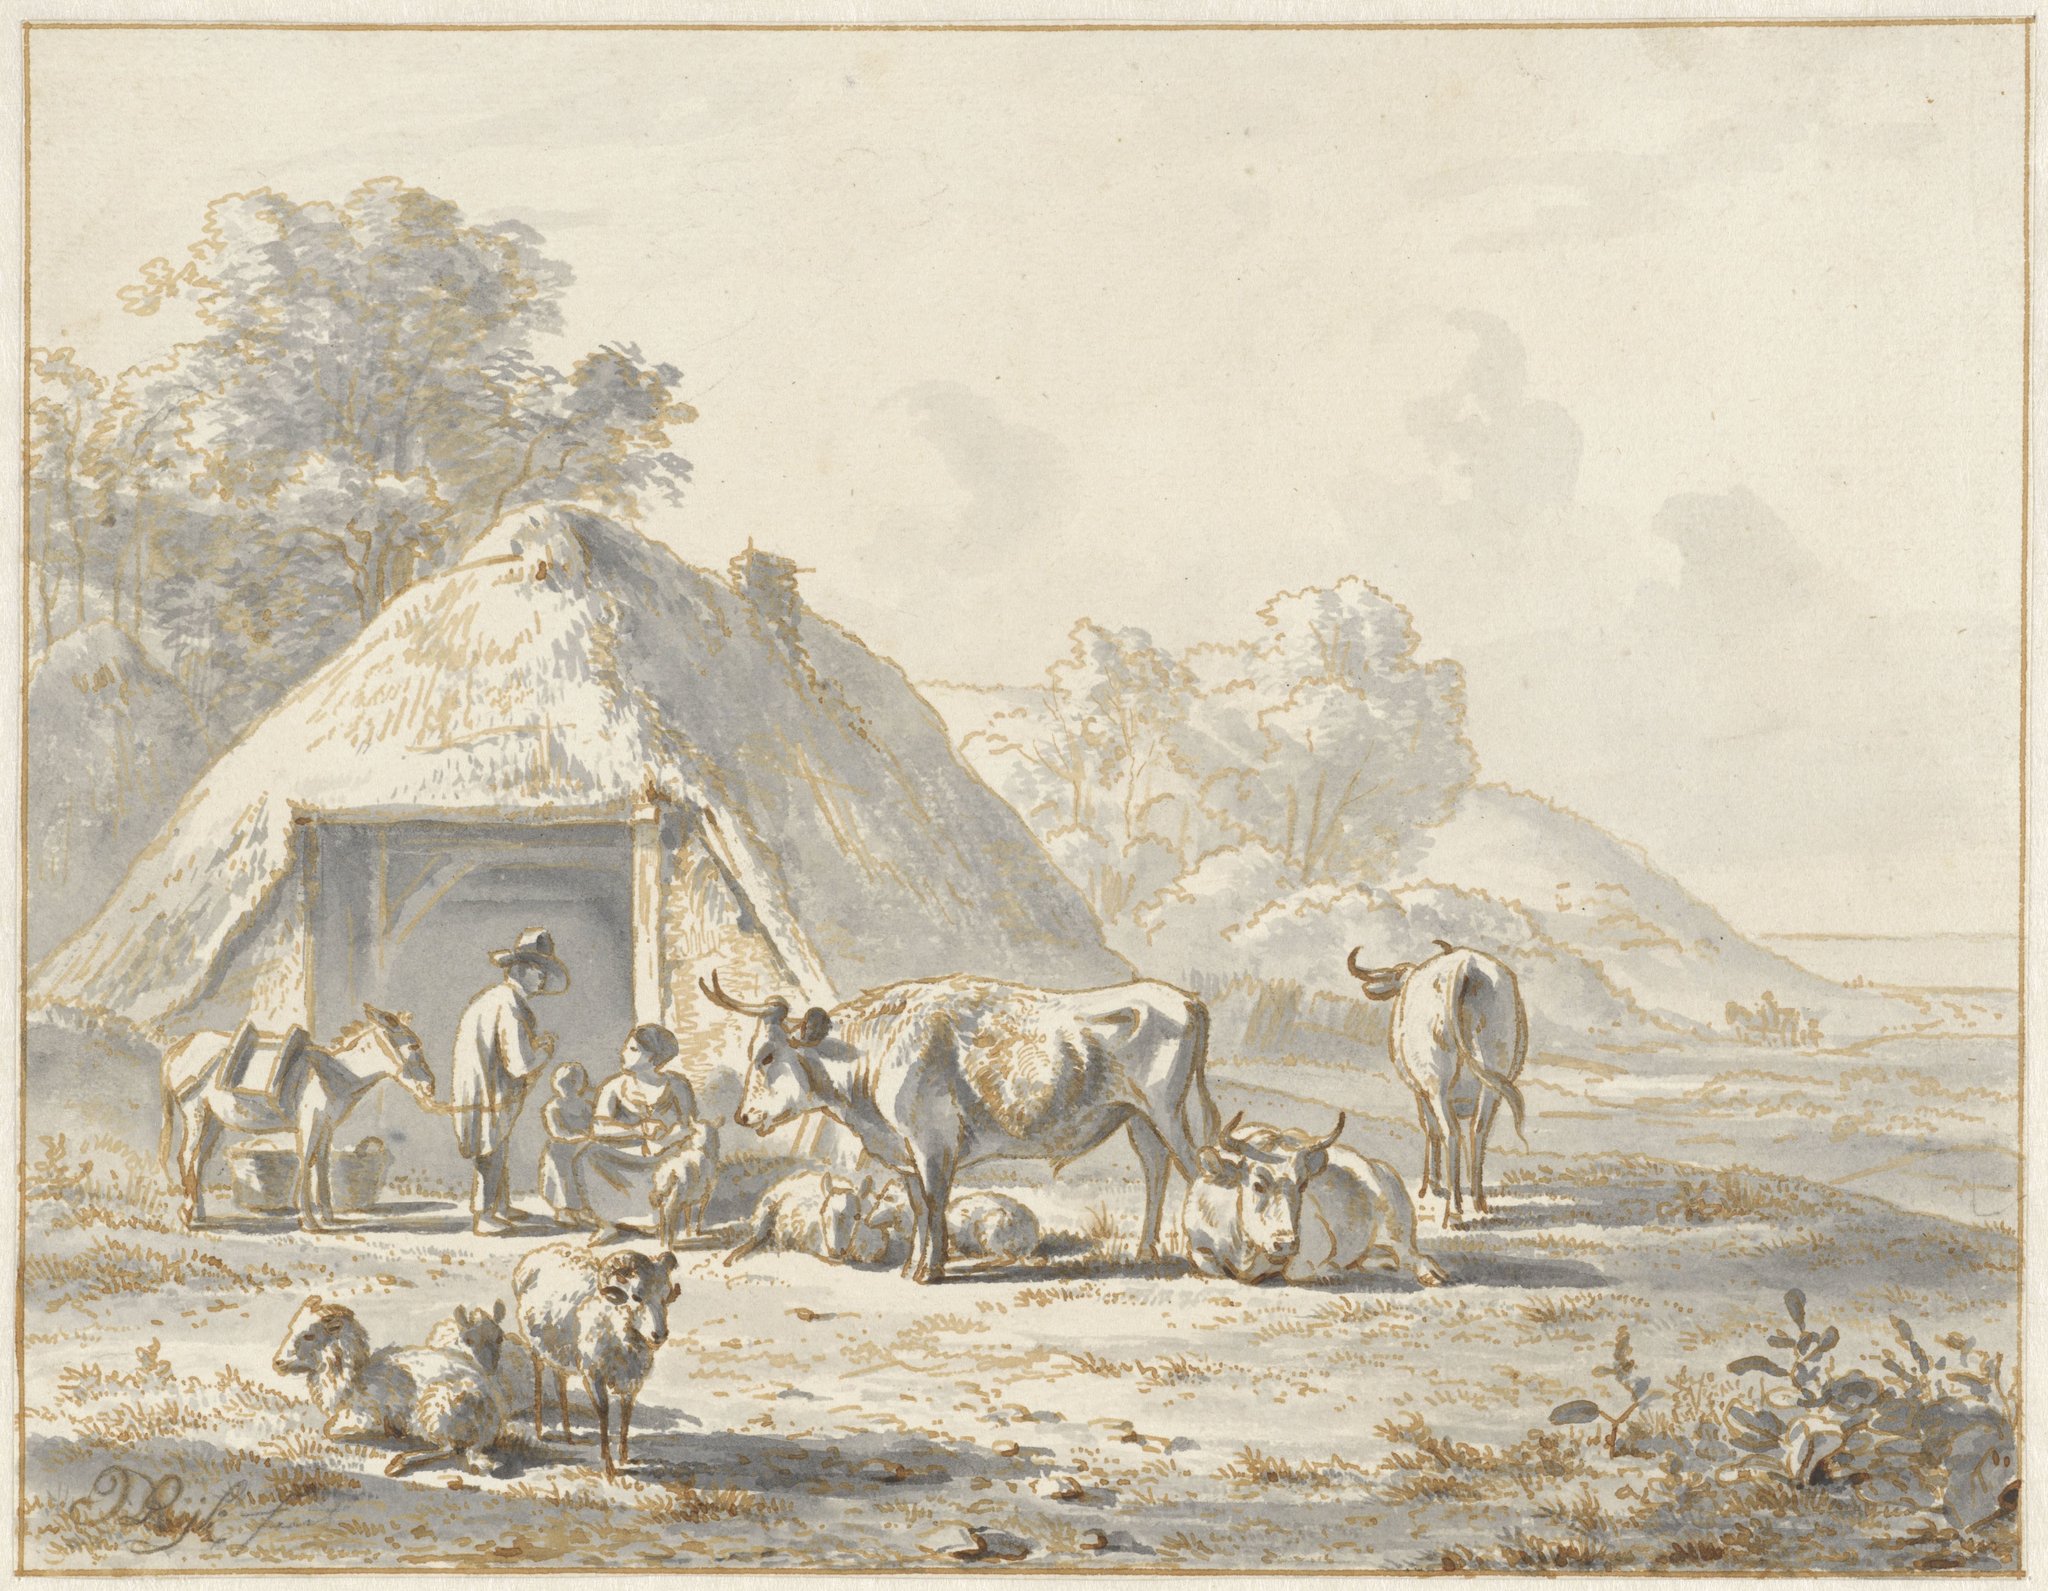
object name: drawing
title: Vee en figuren voor een boerenschuur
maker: james de rijk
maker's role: draughtsman, painter, print maker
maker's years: 1806-1882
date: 1816-1882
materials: ink, paper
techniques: brush, pen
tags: cattle, farm or solitary house in landscape